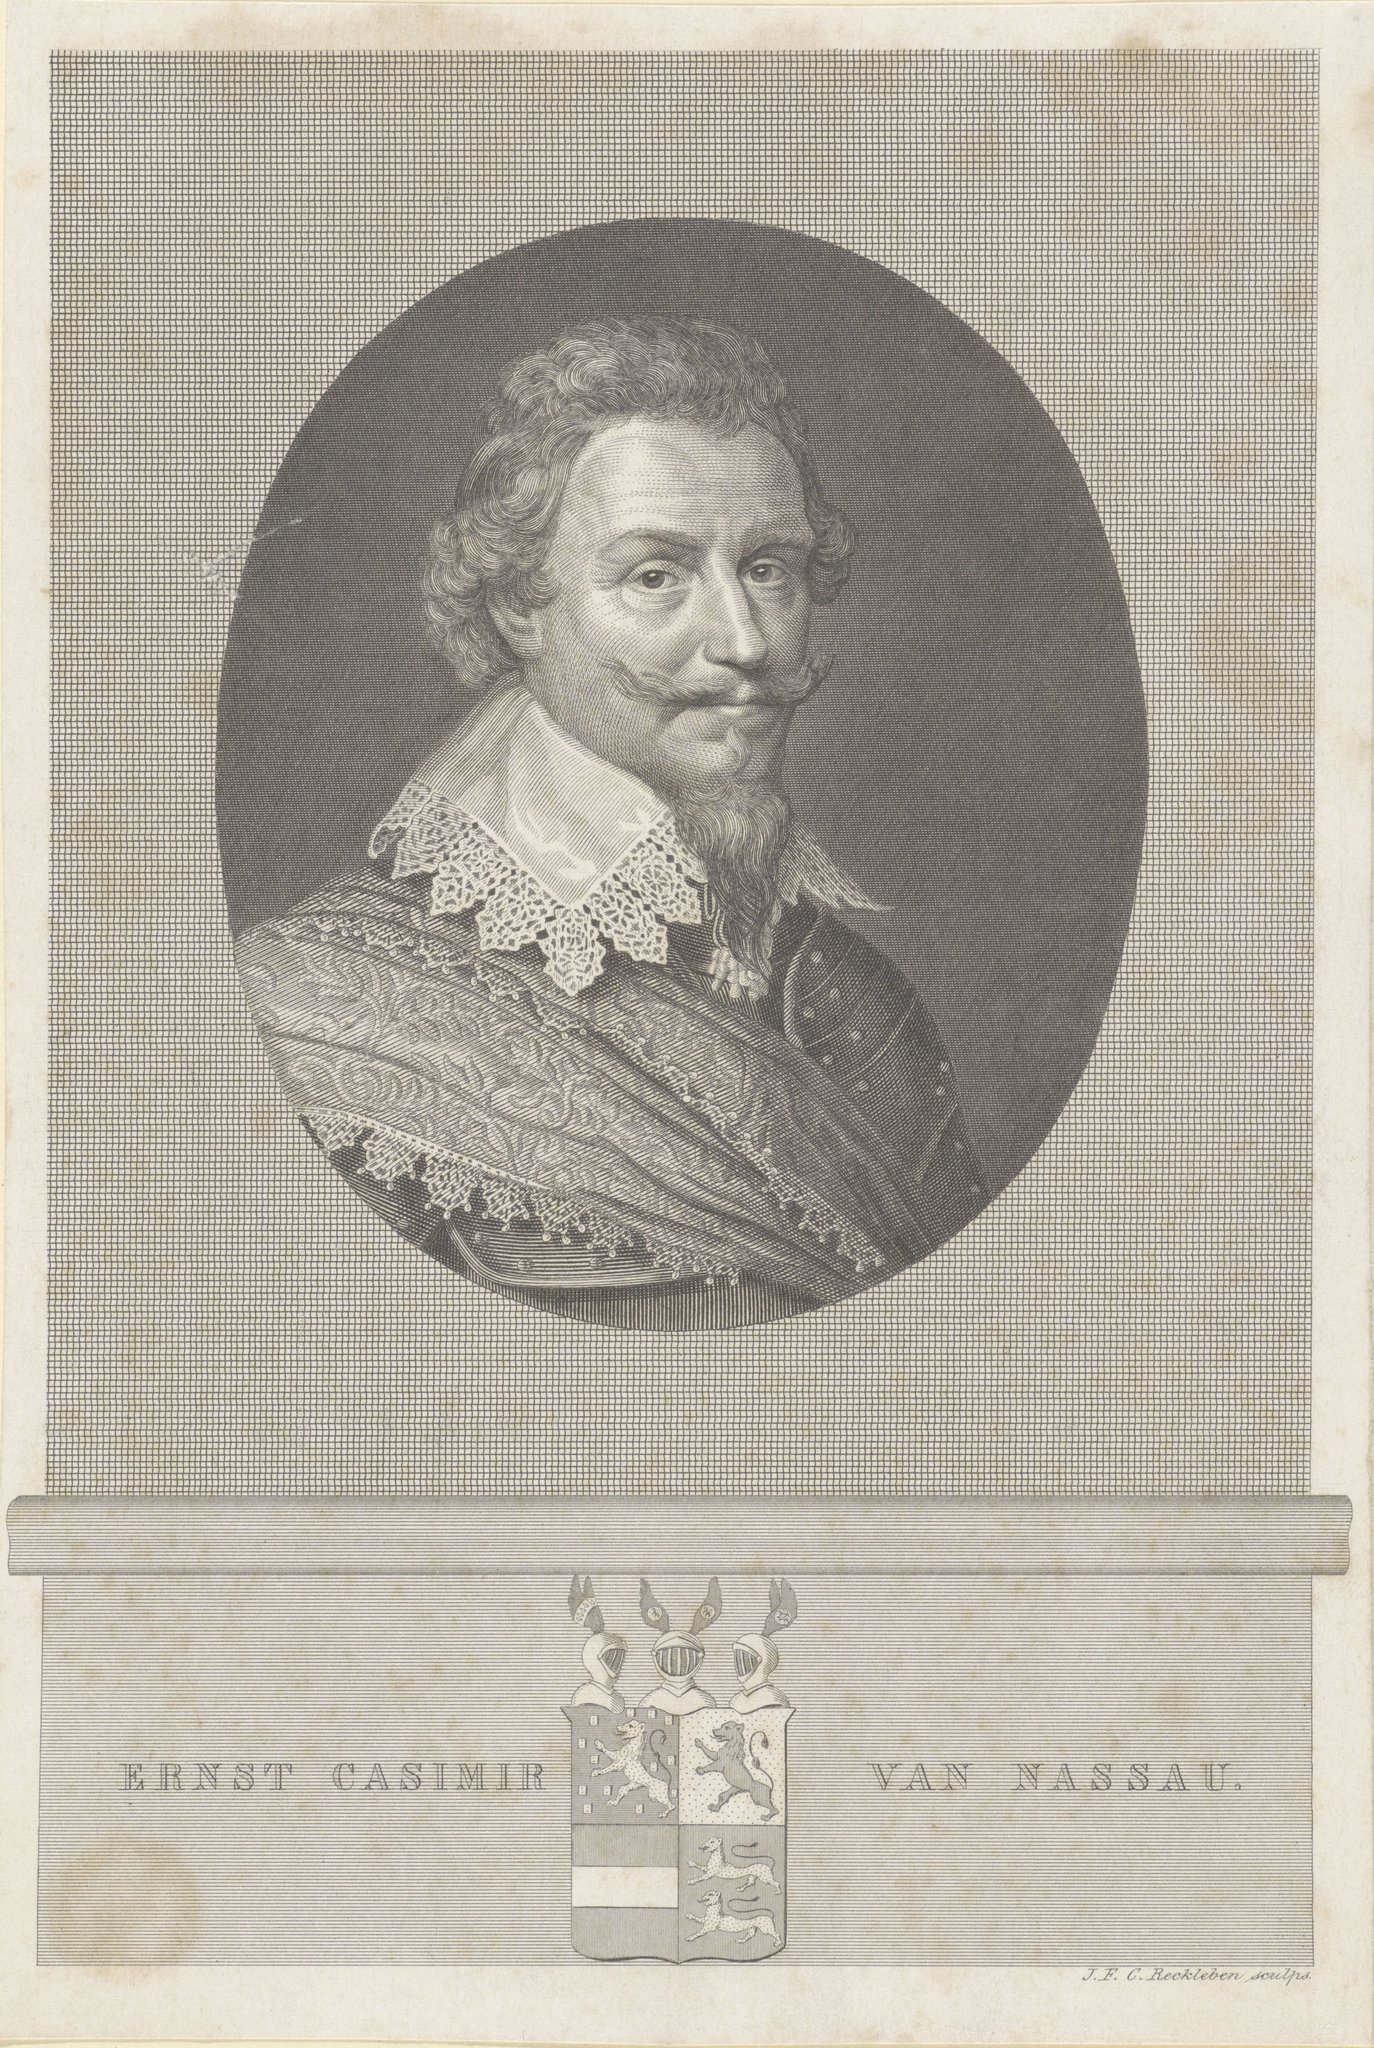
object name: book illustration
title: Portret van Ernst Casimir, graaf van Nassau-Dietz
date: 1840-1884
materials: paper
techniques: engraving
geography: amsterdam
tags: ernst casimir graaf van nassau-dietz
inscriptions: collector's mark: Lugt 2228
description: De hier vermelde titel verwijst naar de hoogst verkregen titel van de geportretteerde, niet per se naar de titel die de geportretteerde op deze voorstelling draagt. Prent uit: Arend, Johannes Pieter. Algemeene geschiedenis des vaderlands van de vroegste tijden tot op heden. Amsterdam: J.F. Schleijer, 1840-1884.